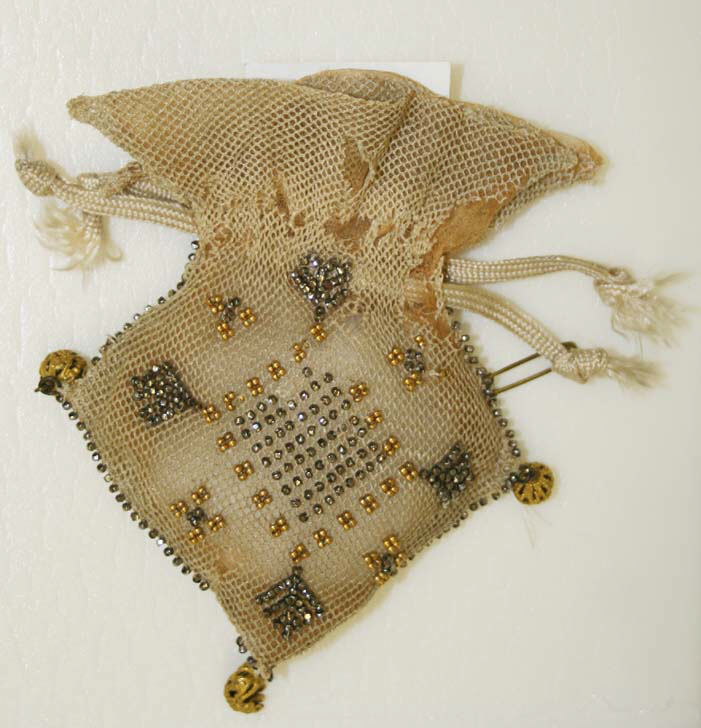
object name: coin purse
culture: american or european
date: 1799-1820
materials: metal, silk